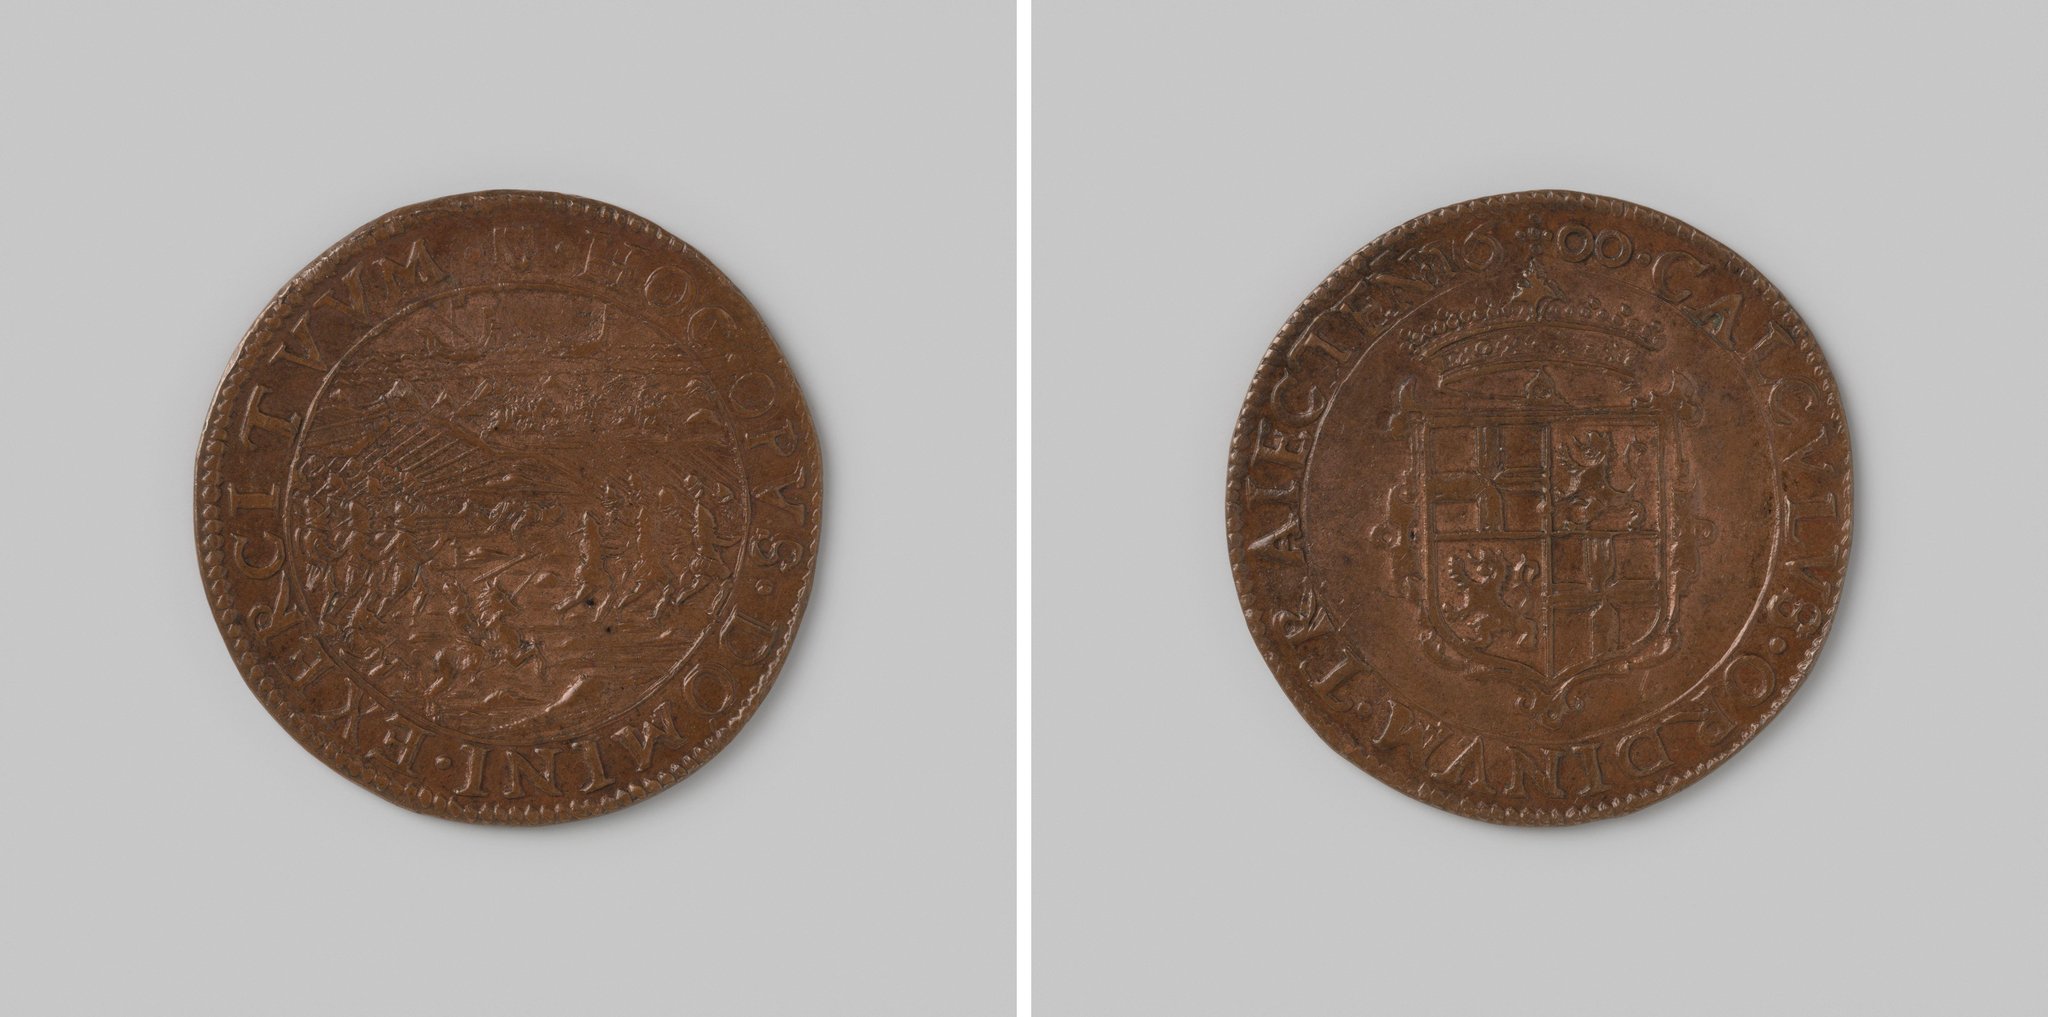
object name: history medal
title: Rekenpenning uit Utrecht voor de Staten van Utrecht op de overwinning in de Slag bij Nieuwpoort 1600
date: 1600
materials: copper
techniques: striking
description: Koperen penning, op de voorzijde het aanzicht van de veldslag, met omschrift, op de keerzijde het gekroonde wapenschild van de provincie Utrecht omhangen met omschrift.